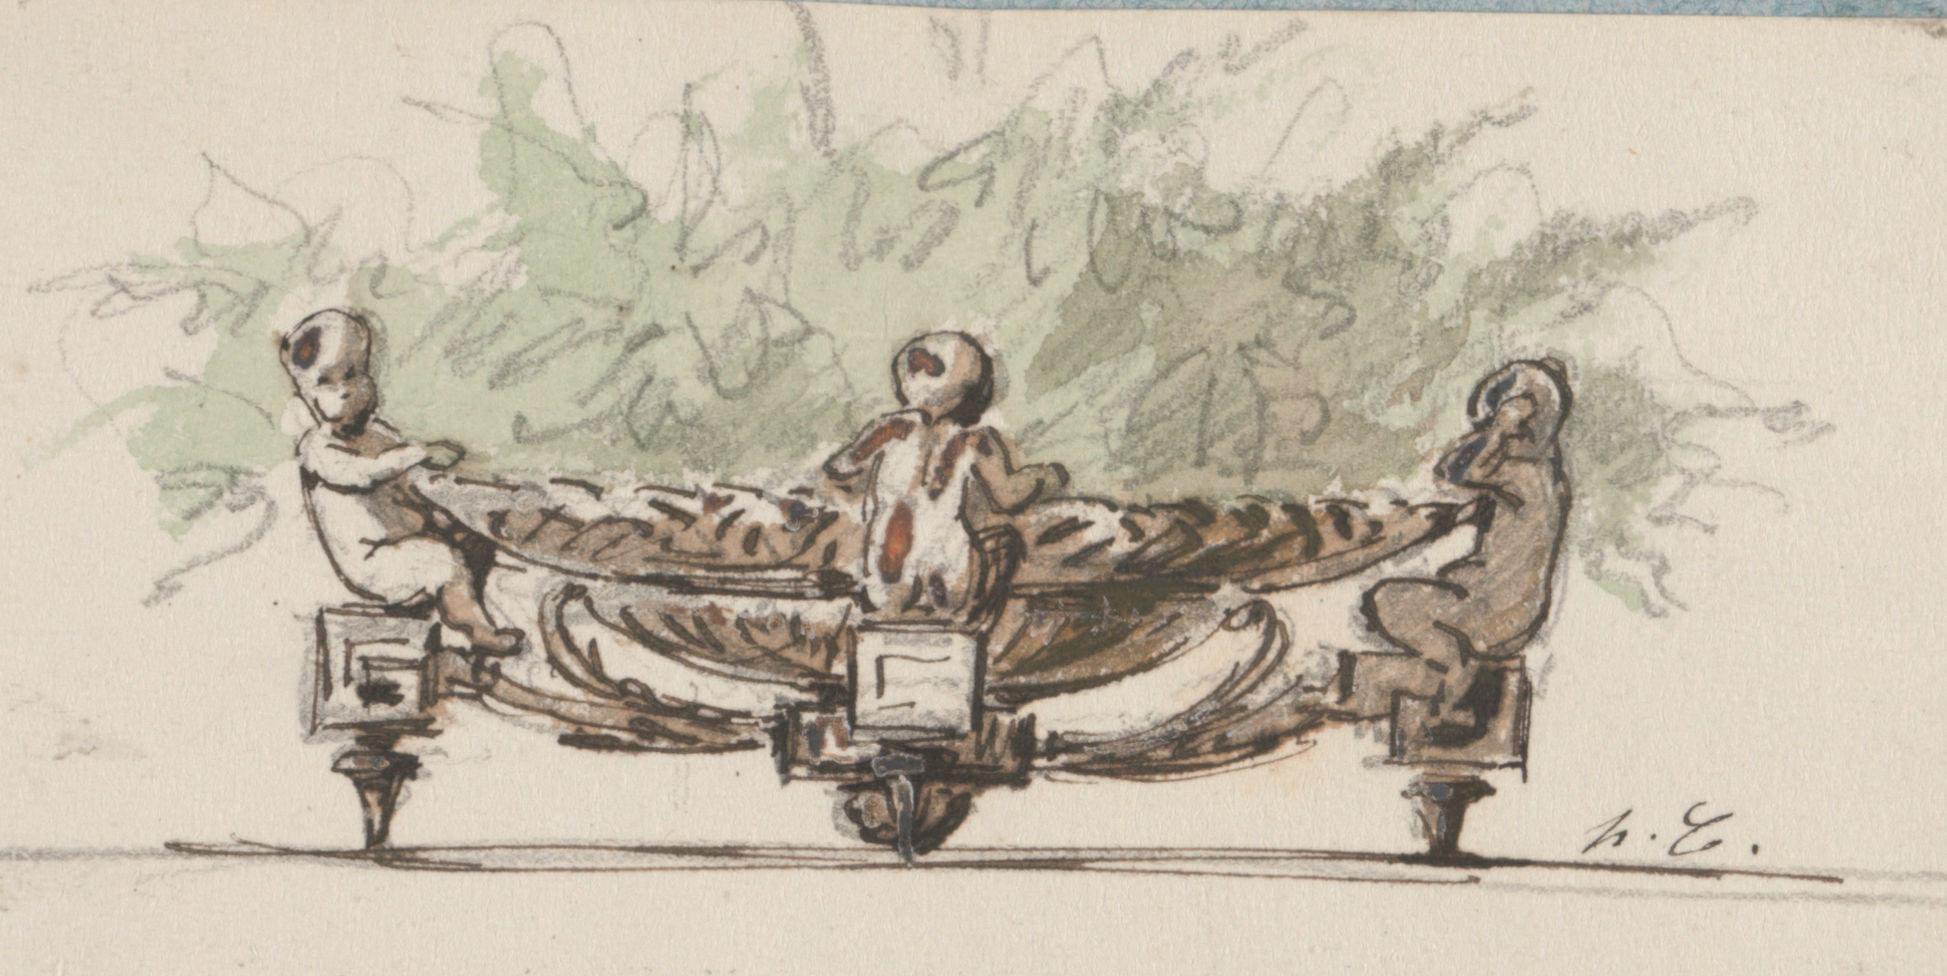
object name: design drawing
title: Ontwerp voor jardinière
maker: henri cameré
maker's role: designer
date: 1864-1894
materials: paint, ink, paper, pencil, watercolor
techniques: brush, pen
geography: paris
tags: potted plants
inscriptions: signature: ‘h.C.’